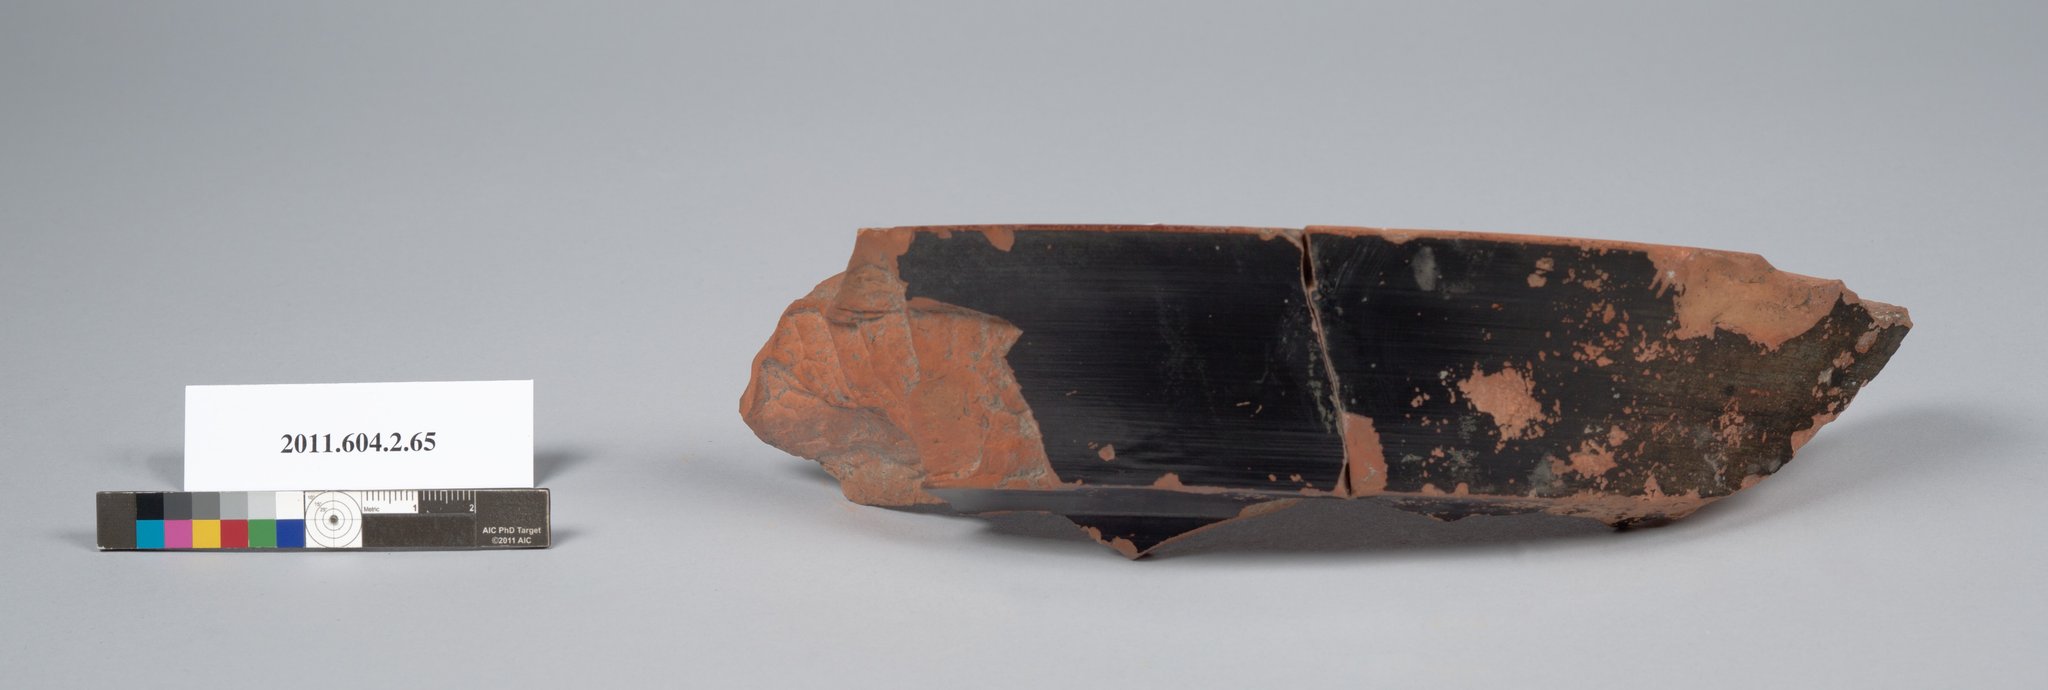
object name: amphora fragment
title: Terracotta fragment of an amphora (jar)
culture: greek, attic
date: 534-468 BCE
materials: terracotta